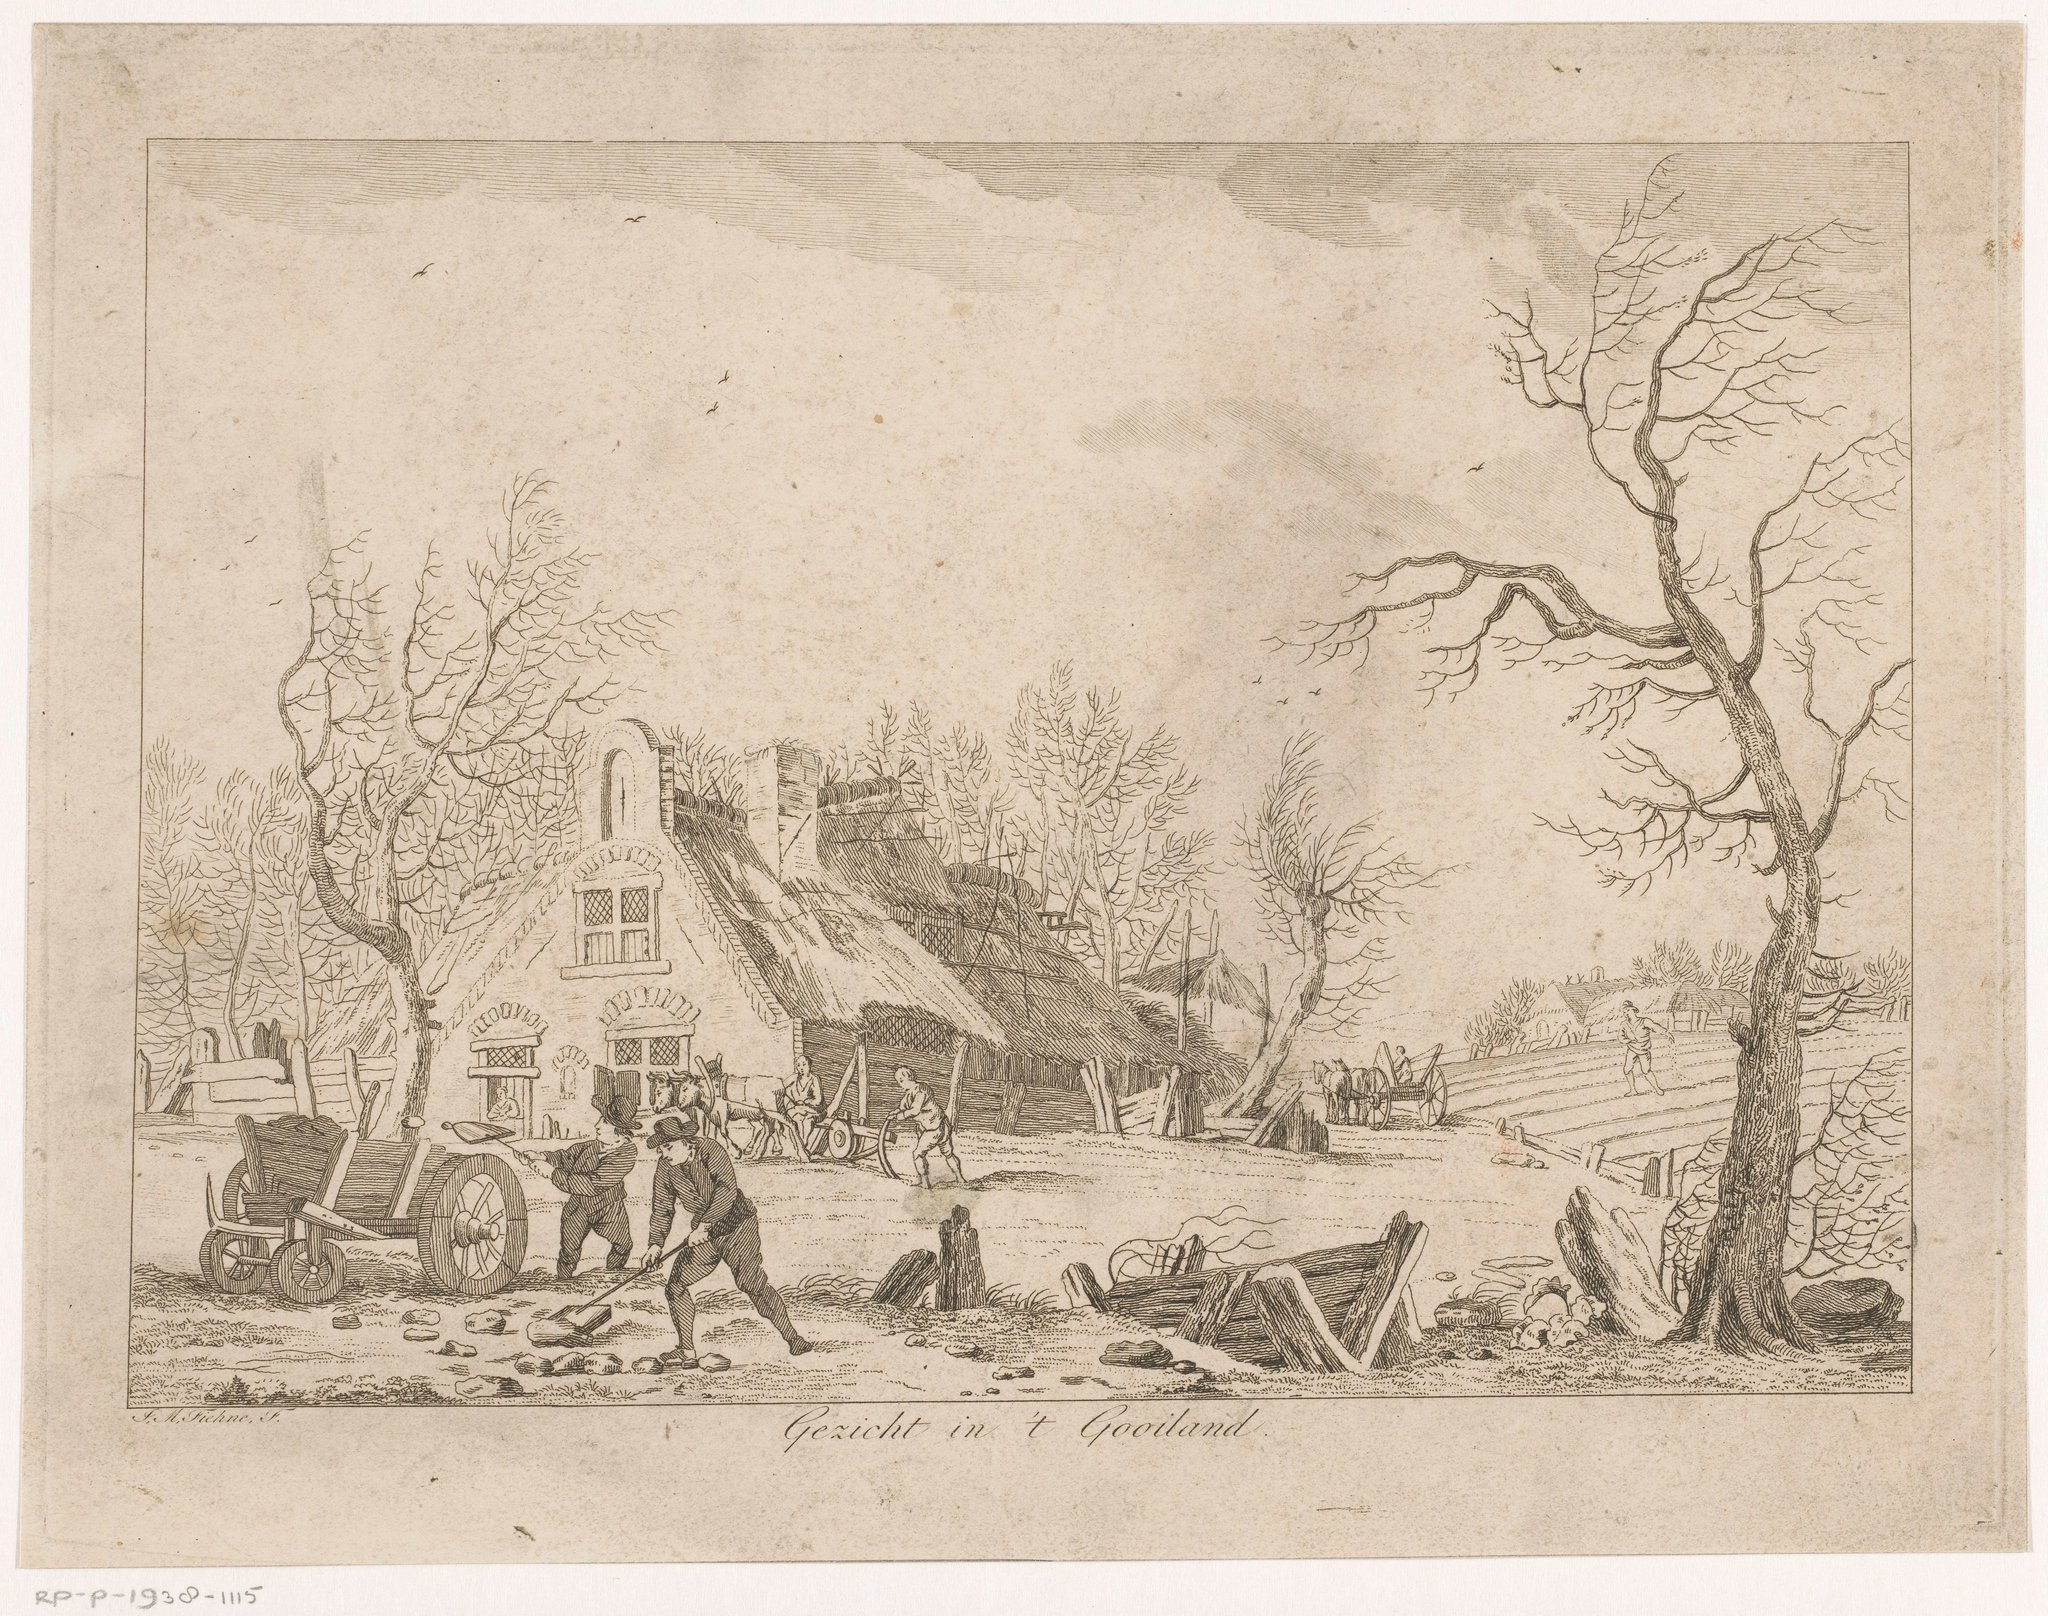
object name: print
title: Gezicht in 't Gooiland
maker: i.m. fiehne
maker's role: print maker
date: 1800-1815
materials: paper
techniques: etching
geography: netherlands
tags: agriculture (+ men (labourers))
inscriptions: collector's mark: Lugt 2760, collector's mark: Lugt 2228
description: Gezicht op het land rondom een boerderij. Op de voorgrond zijn twee mannen stenen in een kar aan het scheppen. Verderop ploegen twee arbeiders het land en op de achtergrond is iemand het land aan het inzaaien.